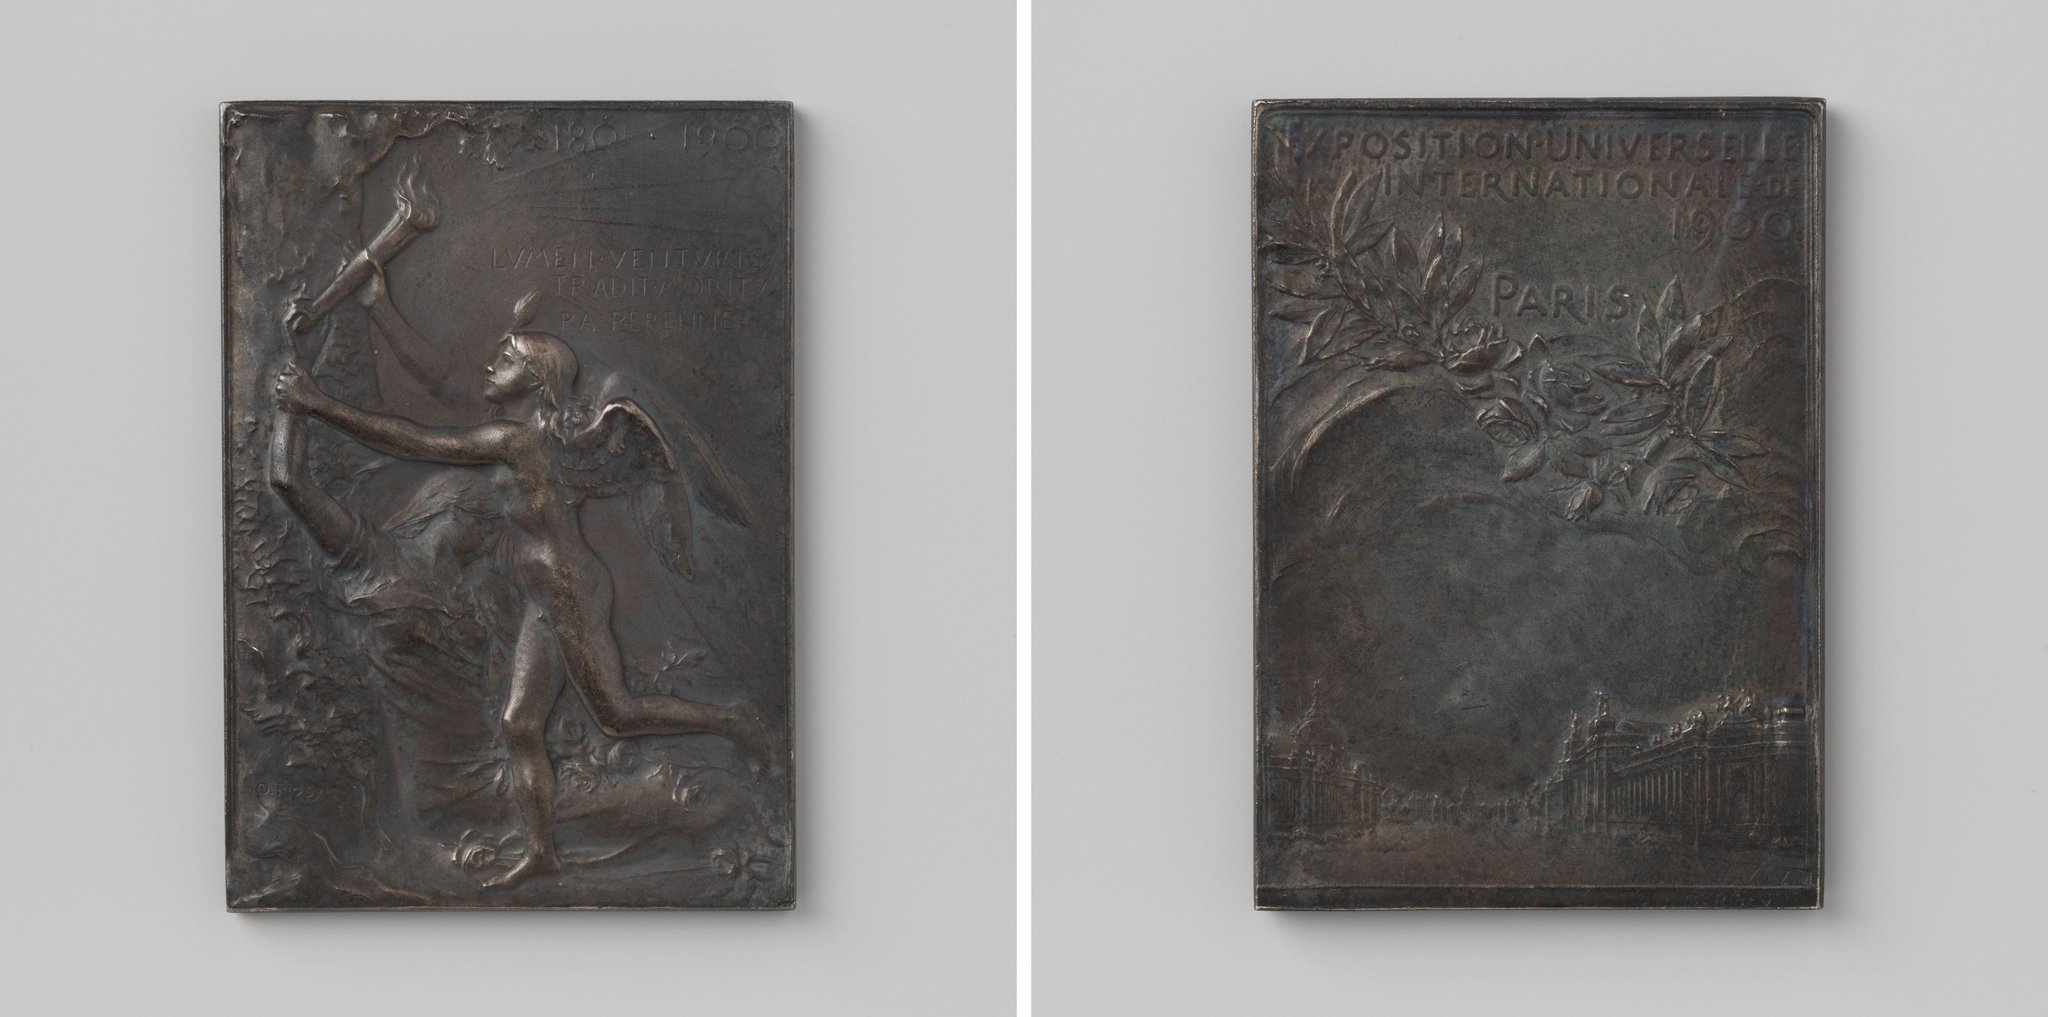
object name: history medal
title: Wereldtentoonstelling te Parijs 1900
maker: oscar roty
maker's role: draughtsman, sculptor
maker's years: 1846-1911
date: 1900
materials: bronze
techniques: striking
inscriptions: hallmark: ‘cornucopiae en BRONZE’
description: Verzilverde rechthoekige plakette, op de voorzijde een jonge Genius die een fakkel overneemt van een oude, vermoeid tegen een boom zittend, met opwaartse en drie regels inwaartse tekst, op de keerzijde vier regels tekst boven lauwer- en rozentakken, waaronder het expositiegebouw.